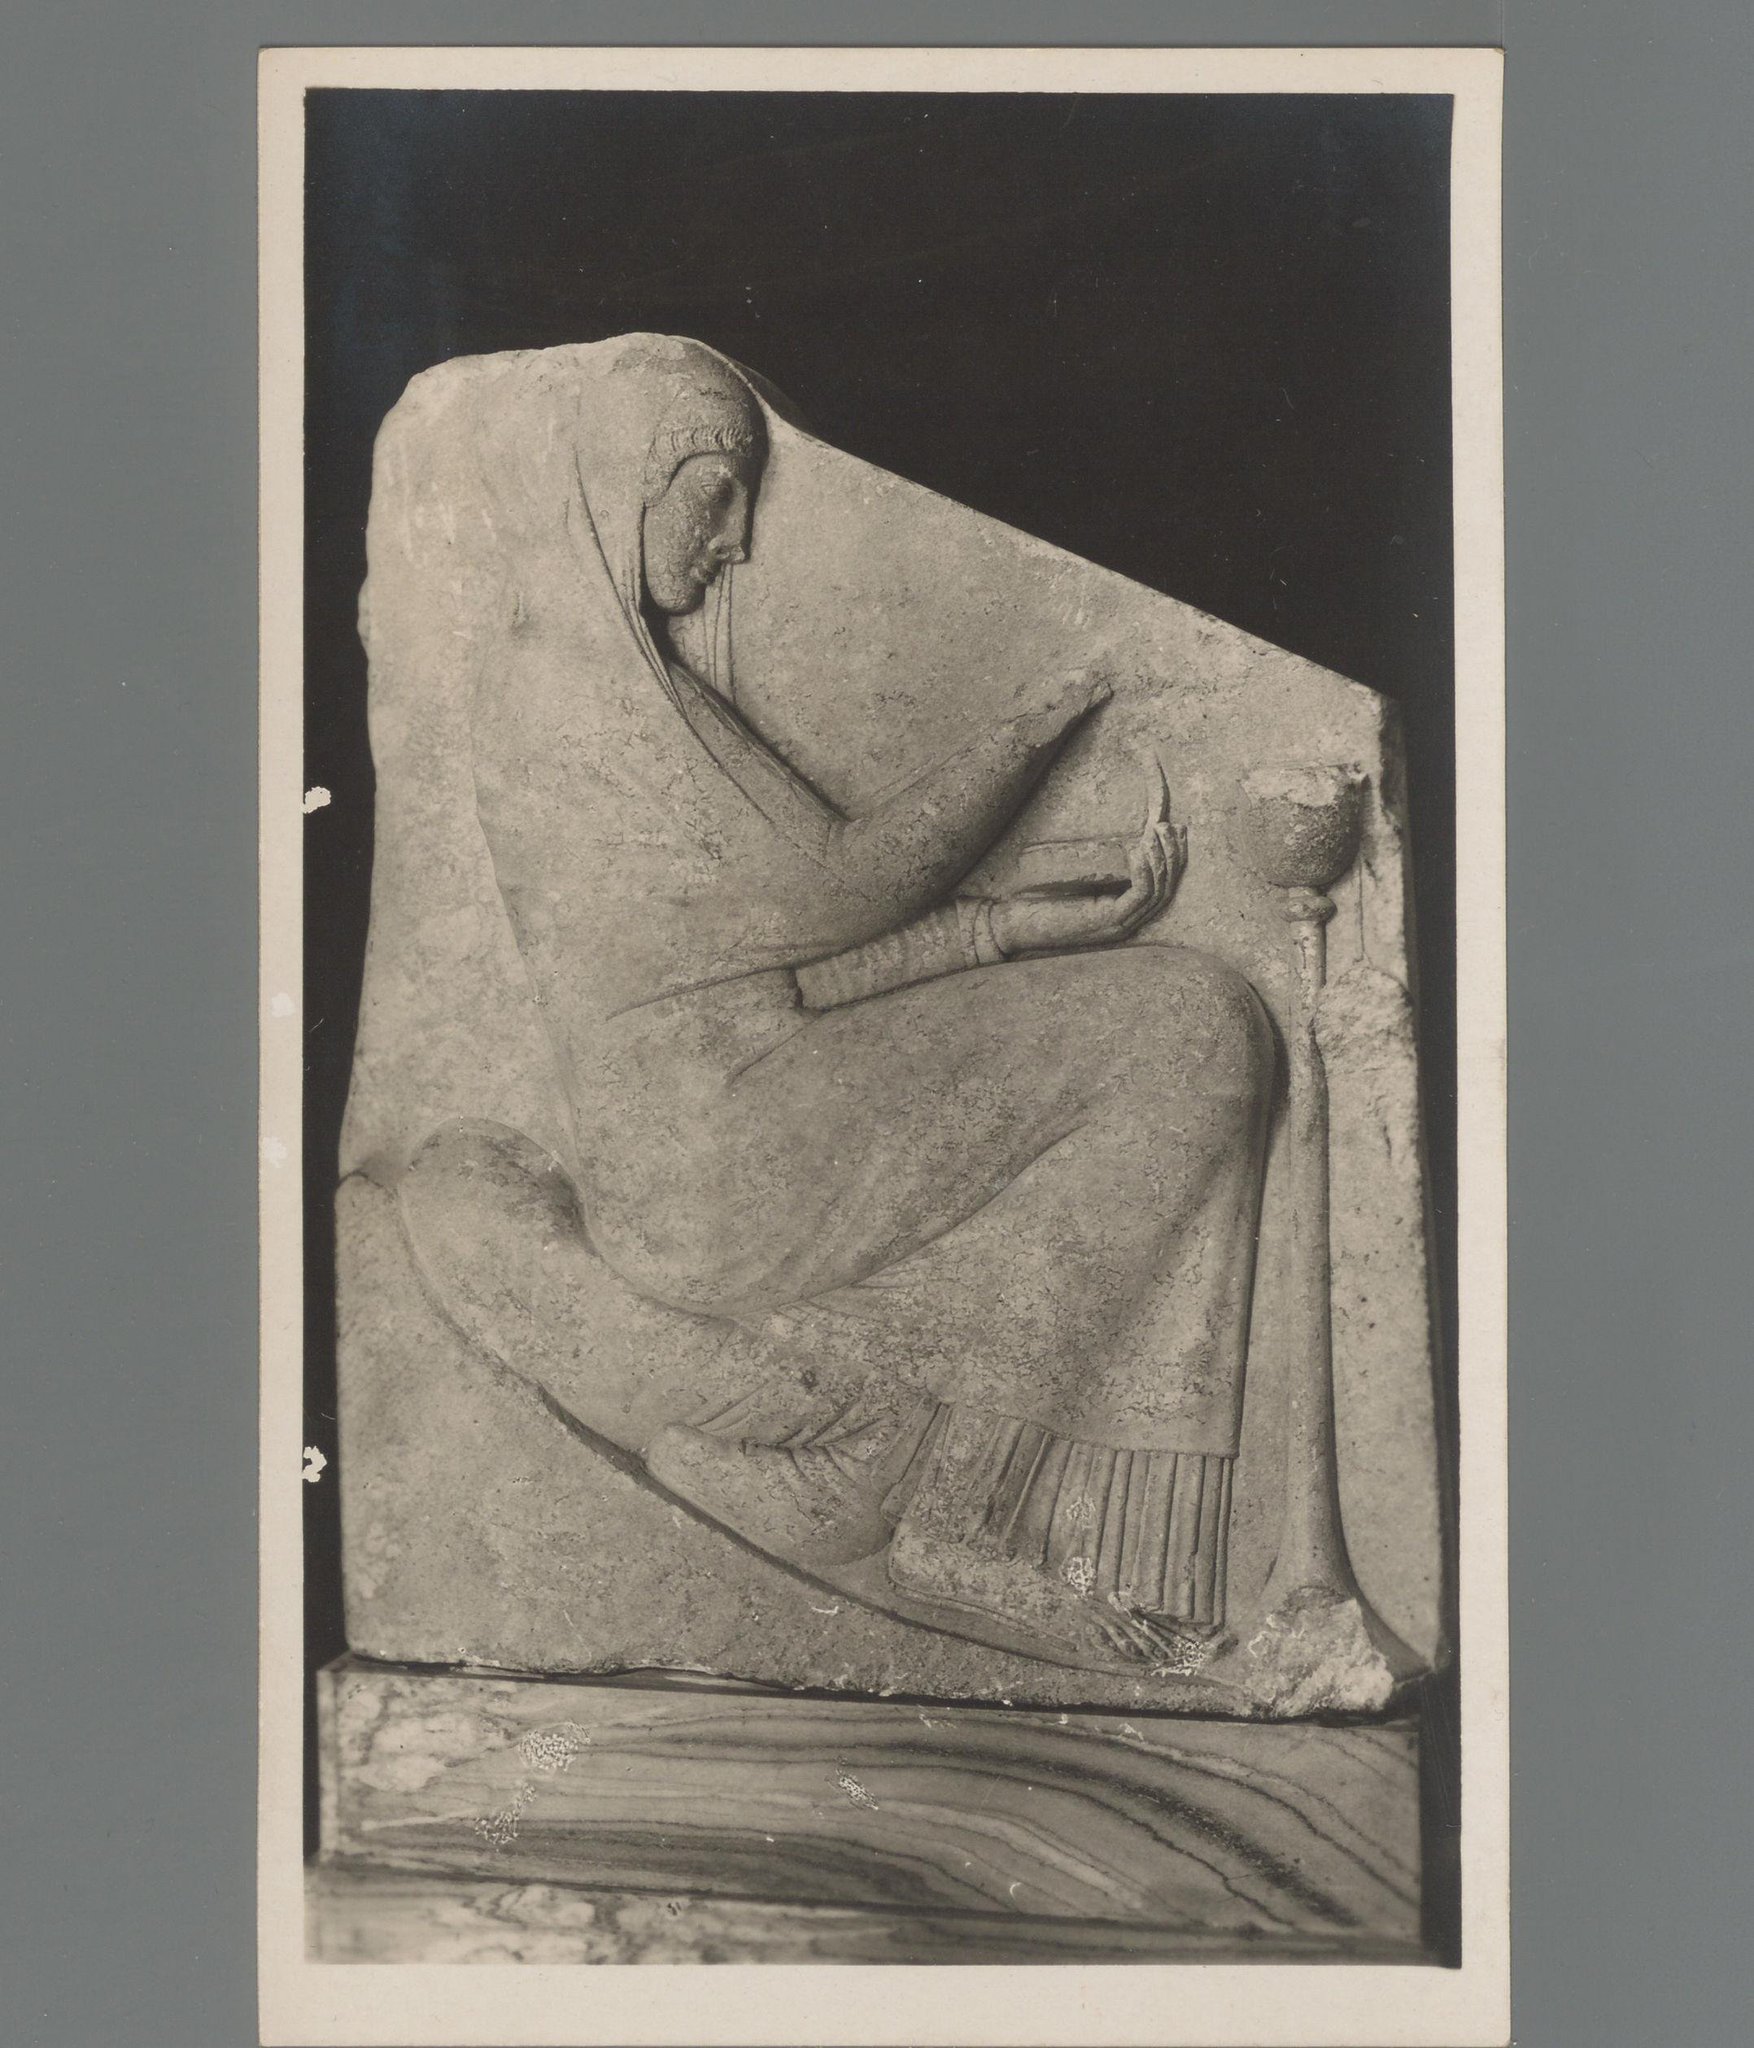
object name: ansichtkaart, prentbriefkaart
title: Roma - Museo Nazionale Romano - Fianco del Trono Ludovisi - Una Offerente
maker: Anonymous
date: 1906-1930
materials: paper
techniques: gelatin silver print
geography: rome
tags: statues, paintings, etc. ~ objects of worship in roman religion, permanent exhibition, museum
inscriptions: collector's mark: ‘AFE v S’